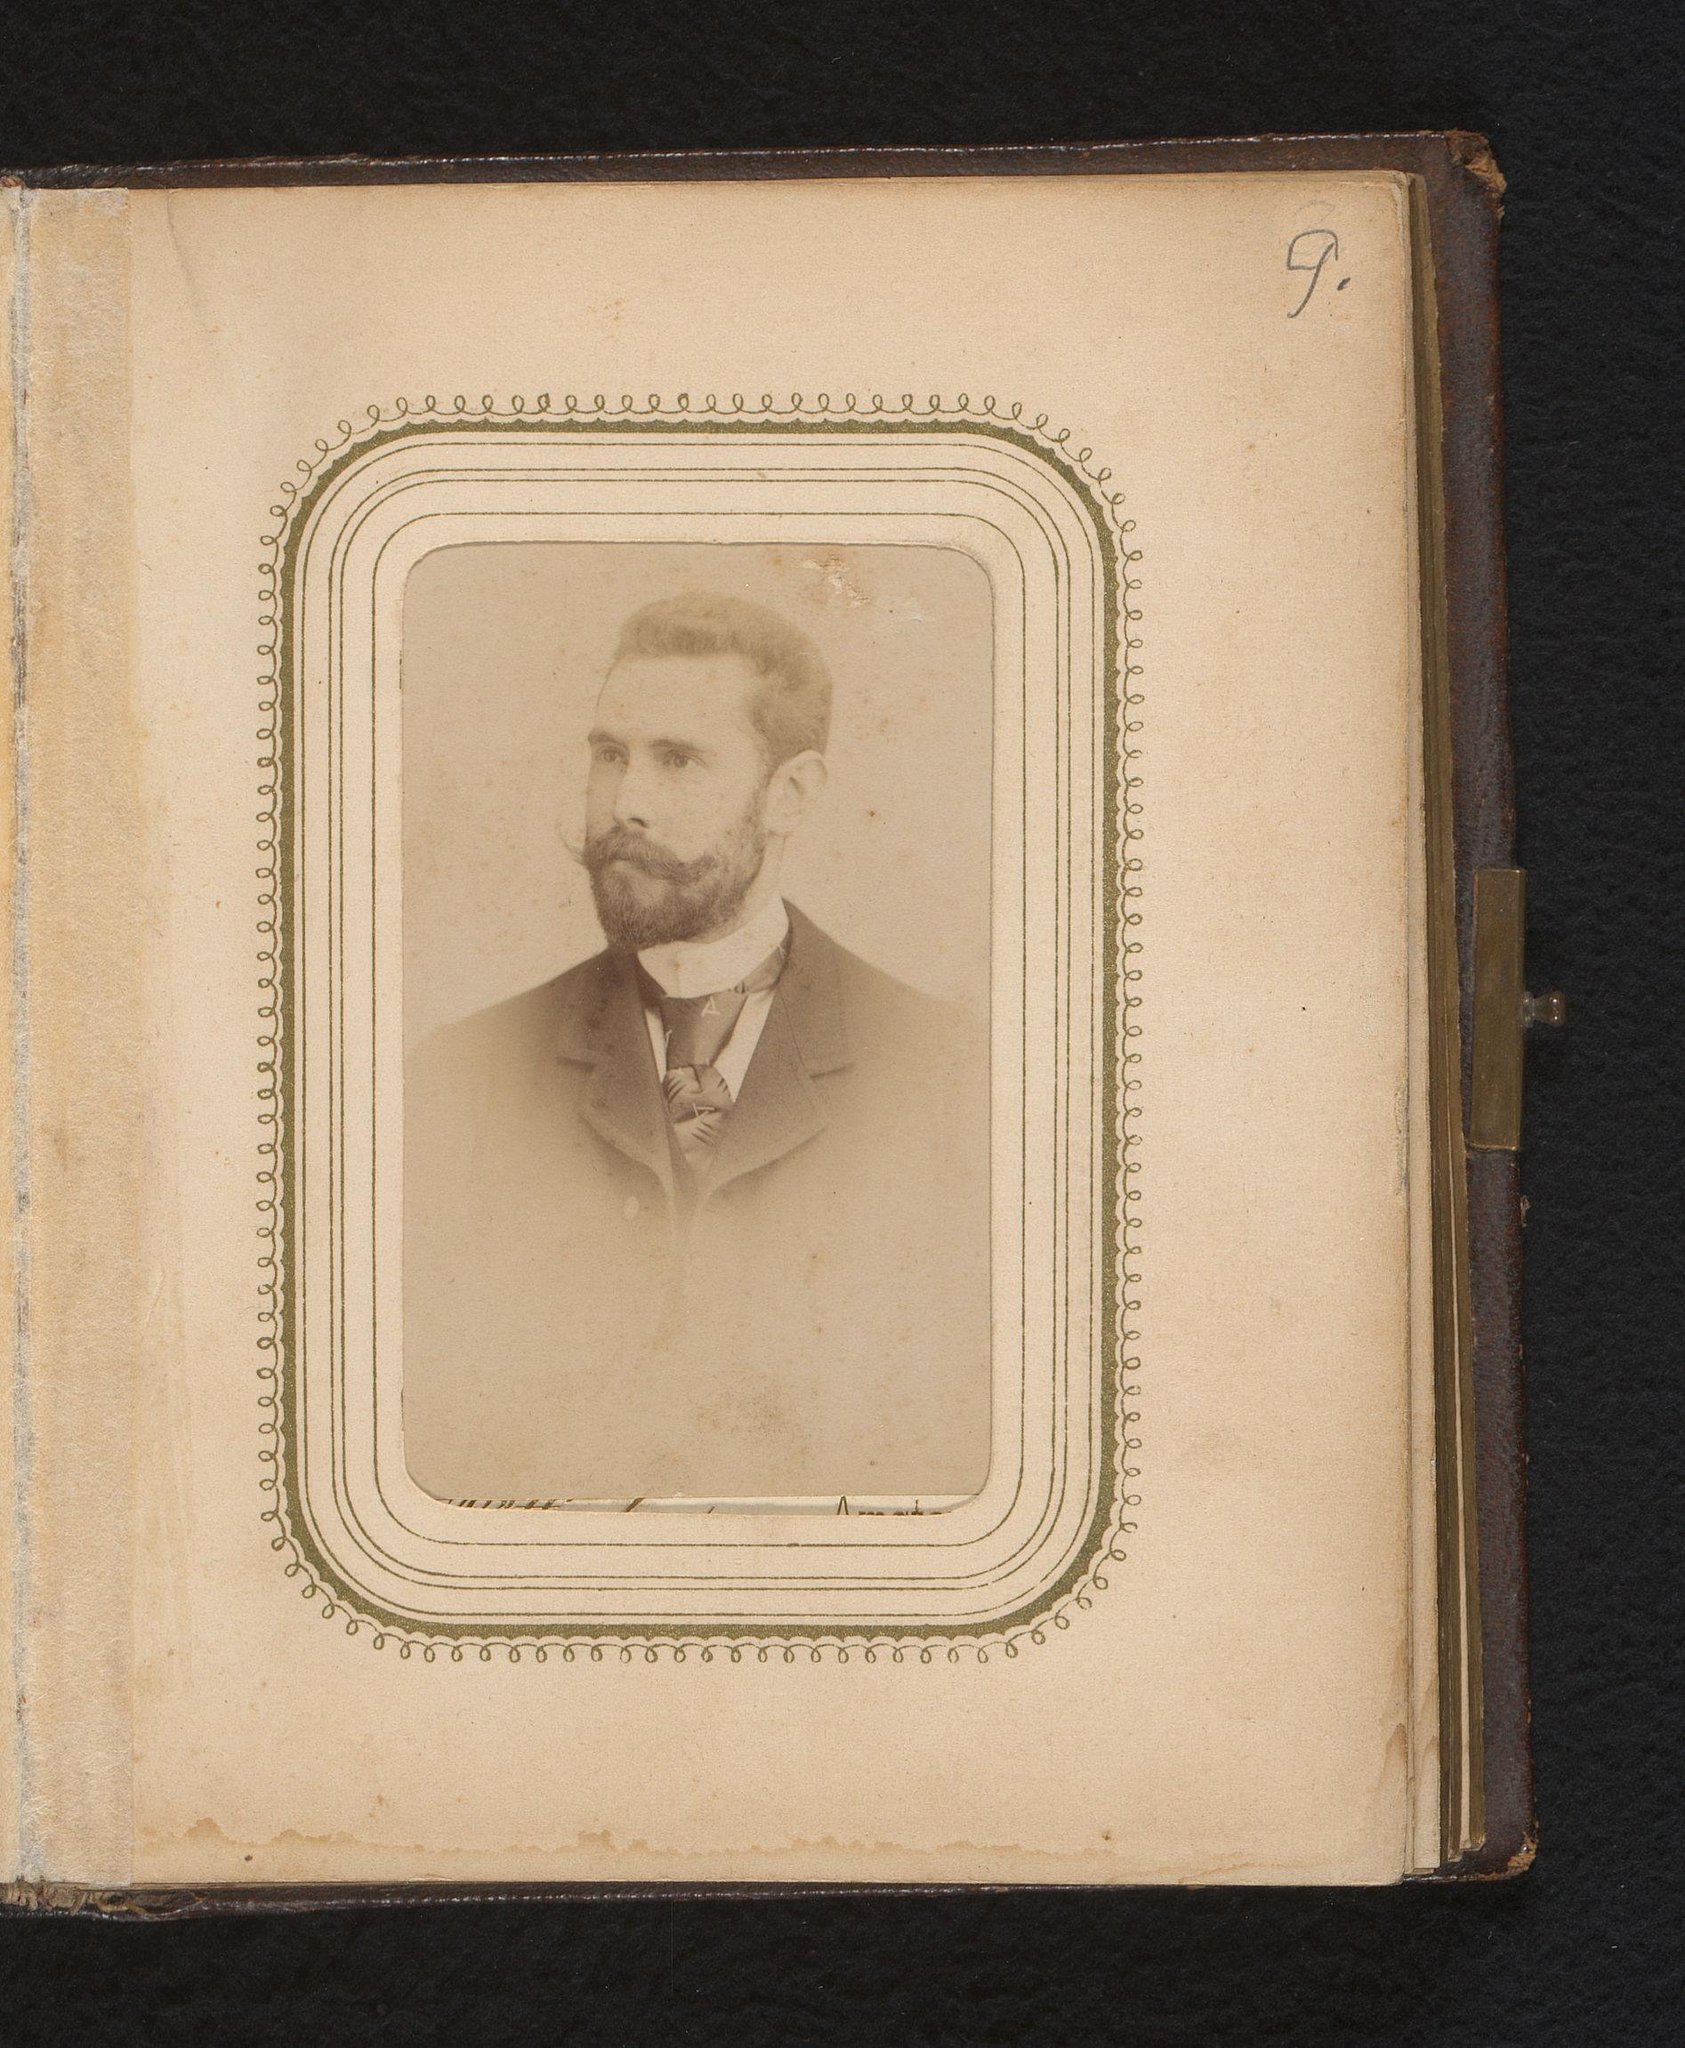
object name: carte de visite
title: Portret van Alexander Buys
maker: max büttinghausen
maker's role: fotograaf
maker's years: 1847-1906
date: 1886-1906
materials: cardboard, paper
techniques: albumen print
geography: amsterdam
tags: historical persons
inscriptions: inscription: ‘Specialiteit in Vergrootingen/ Kooldruk/ Onveranderlijk/ M. Bütthinghausen/ Amsterdam/ Eenig Atelier/ Kalverstraat, hoek Spui (...)’, inscription: ‘M. Büttinghausen/ Amsterdam/ Kalverstr., hoek Spui/ Eenig Atelier’